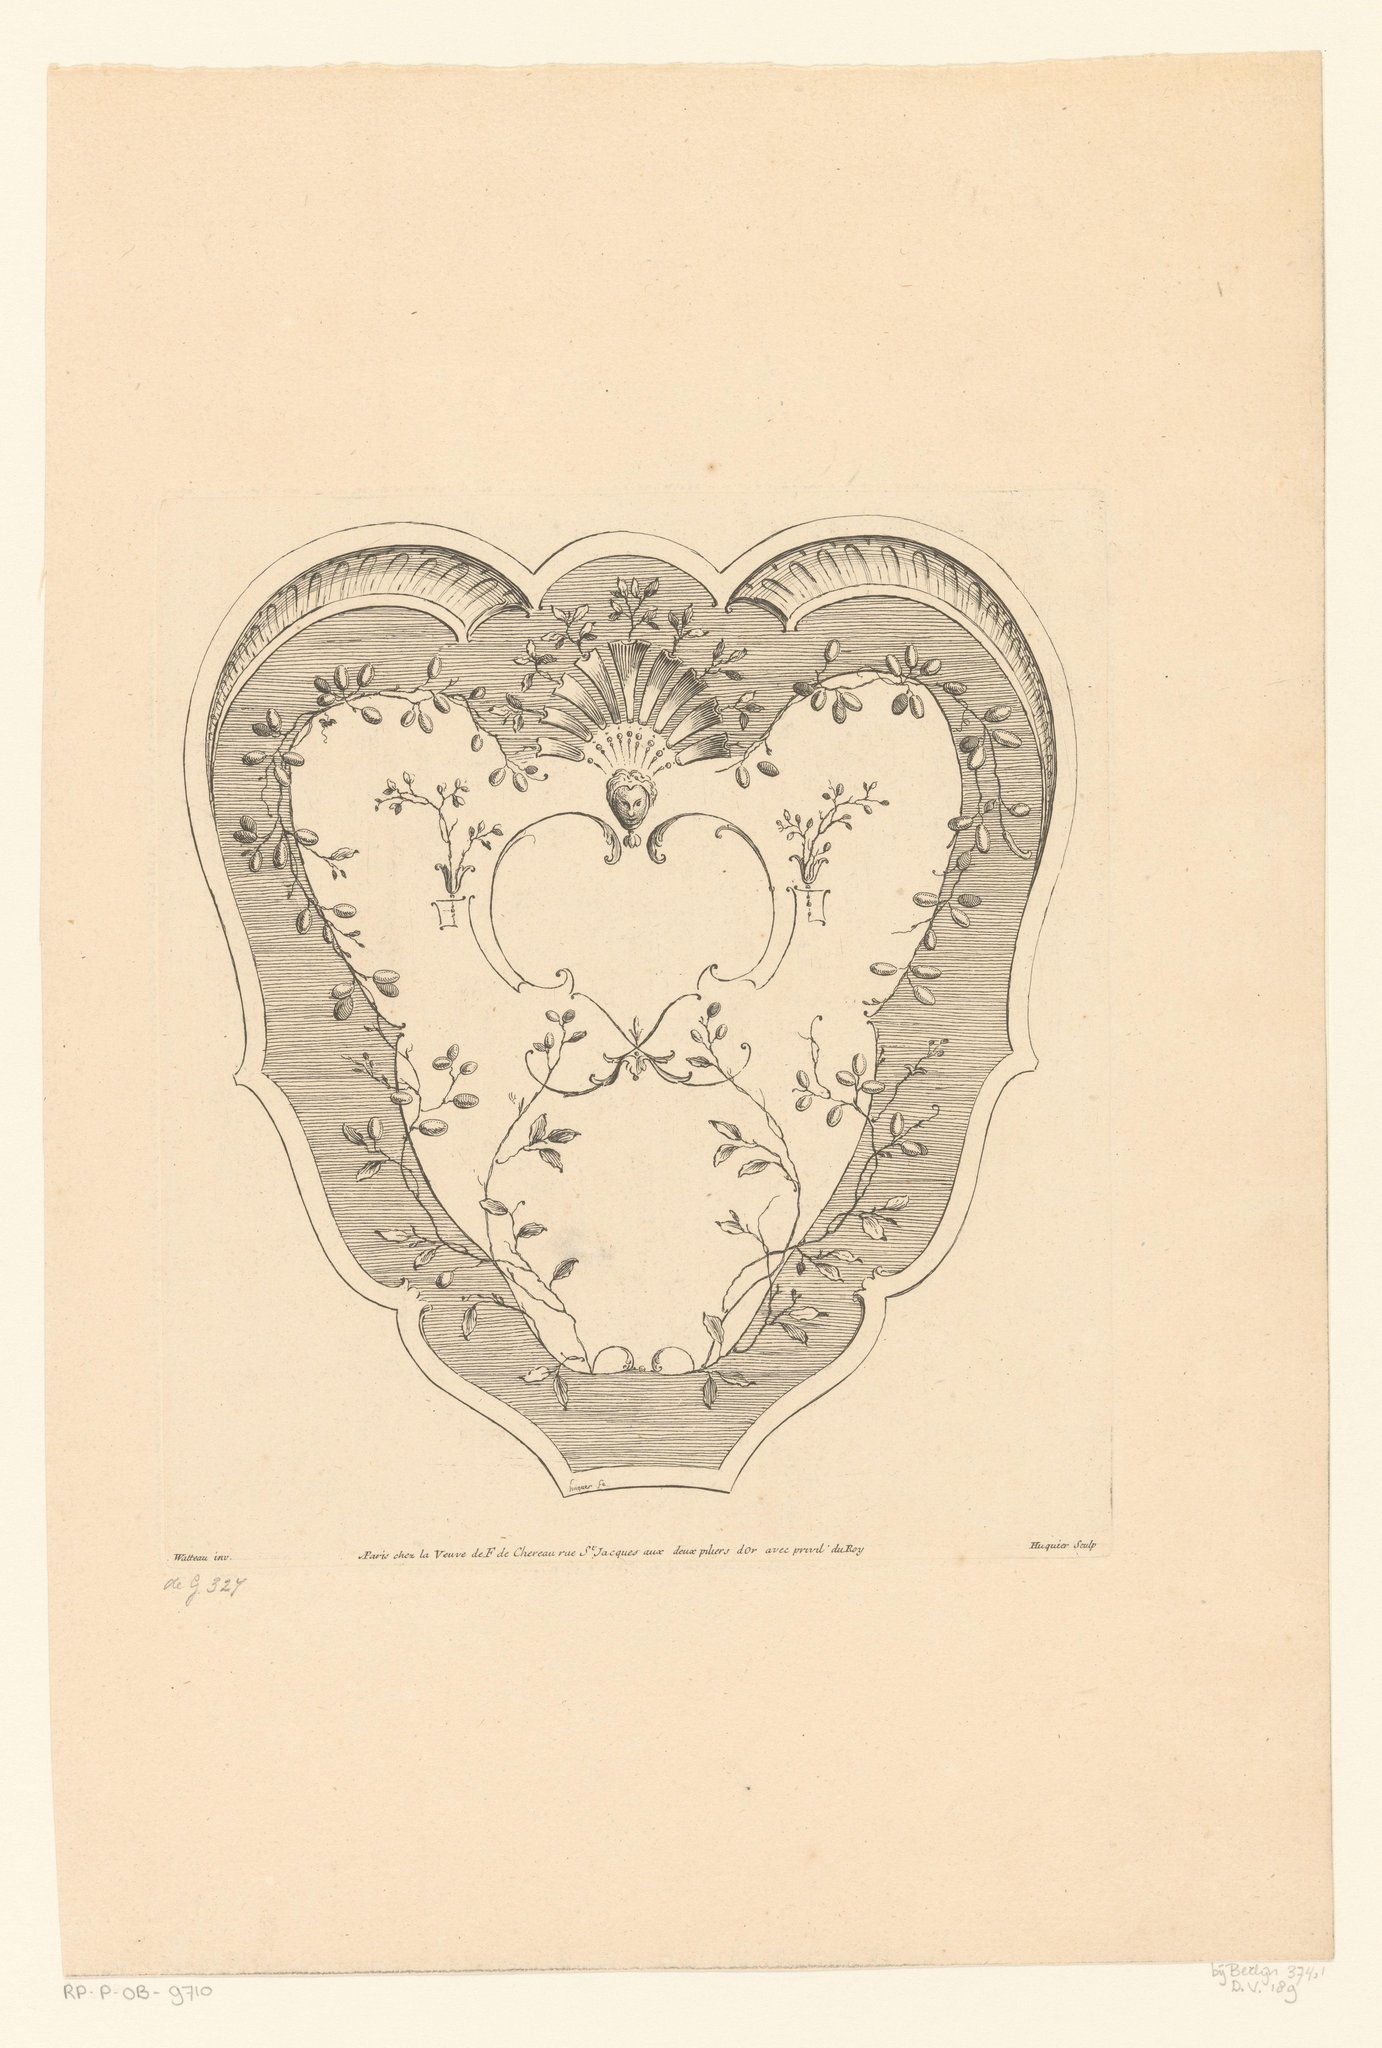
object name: ornament print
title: Hartvorm met masker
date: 1729-1755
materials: paper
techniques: etching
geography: paris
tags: ornaments ~ art (+ framing decorations), mask, mascaron ~ ornament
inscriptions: collector's mark: Lugt 2228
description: Hartvormige omlijsting met rocailles, een masker en takken met vruchten.